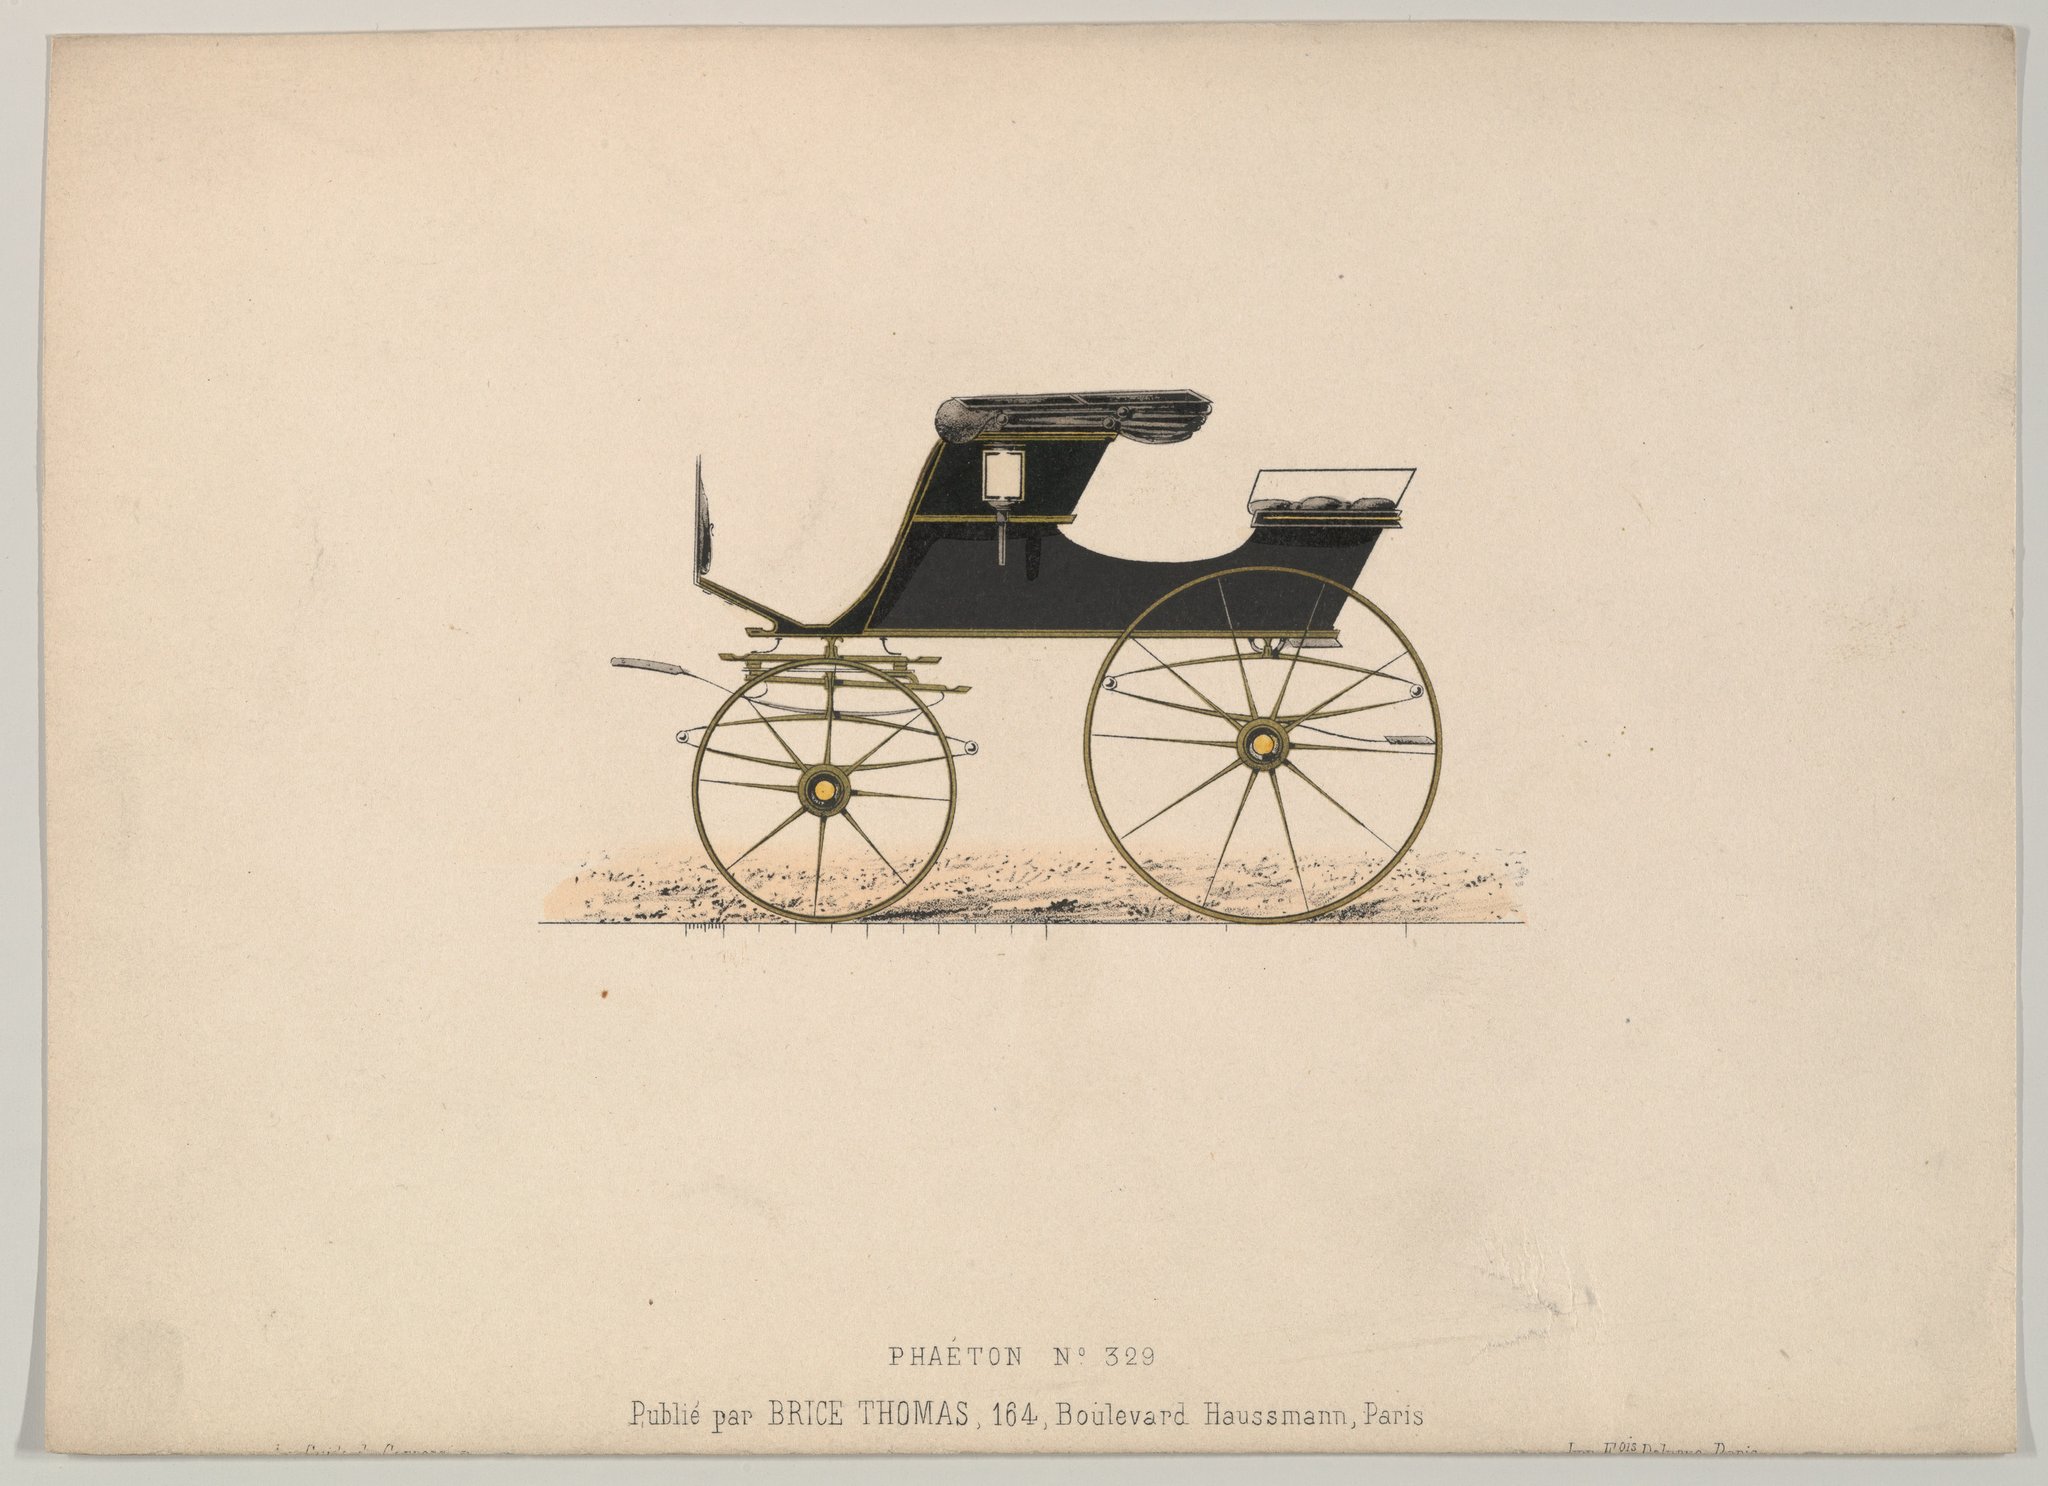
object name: print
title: Design for Phaeton, no. 329, from Le Guide du Carrossier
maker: brice thomas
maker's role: publisher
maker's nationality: french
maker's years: 1830-1890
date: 1870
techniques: hand coloring, lithograph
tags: carriages